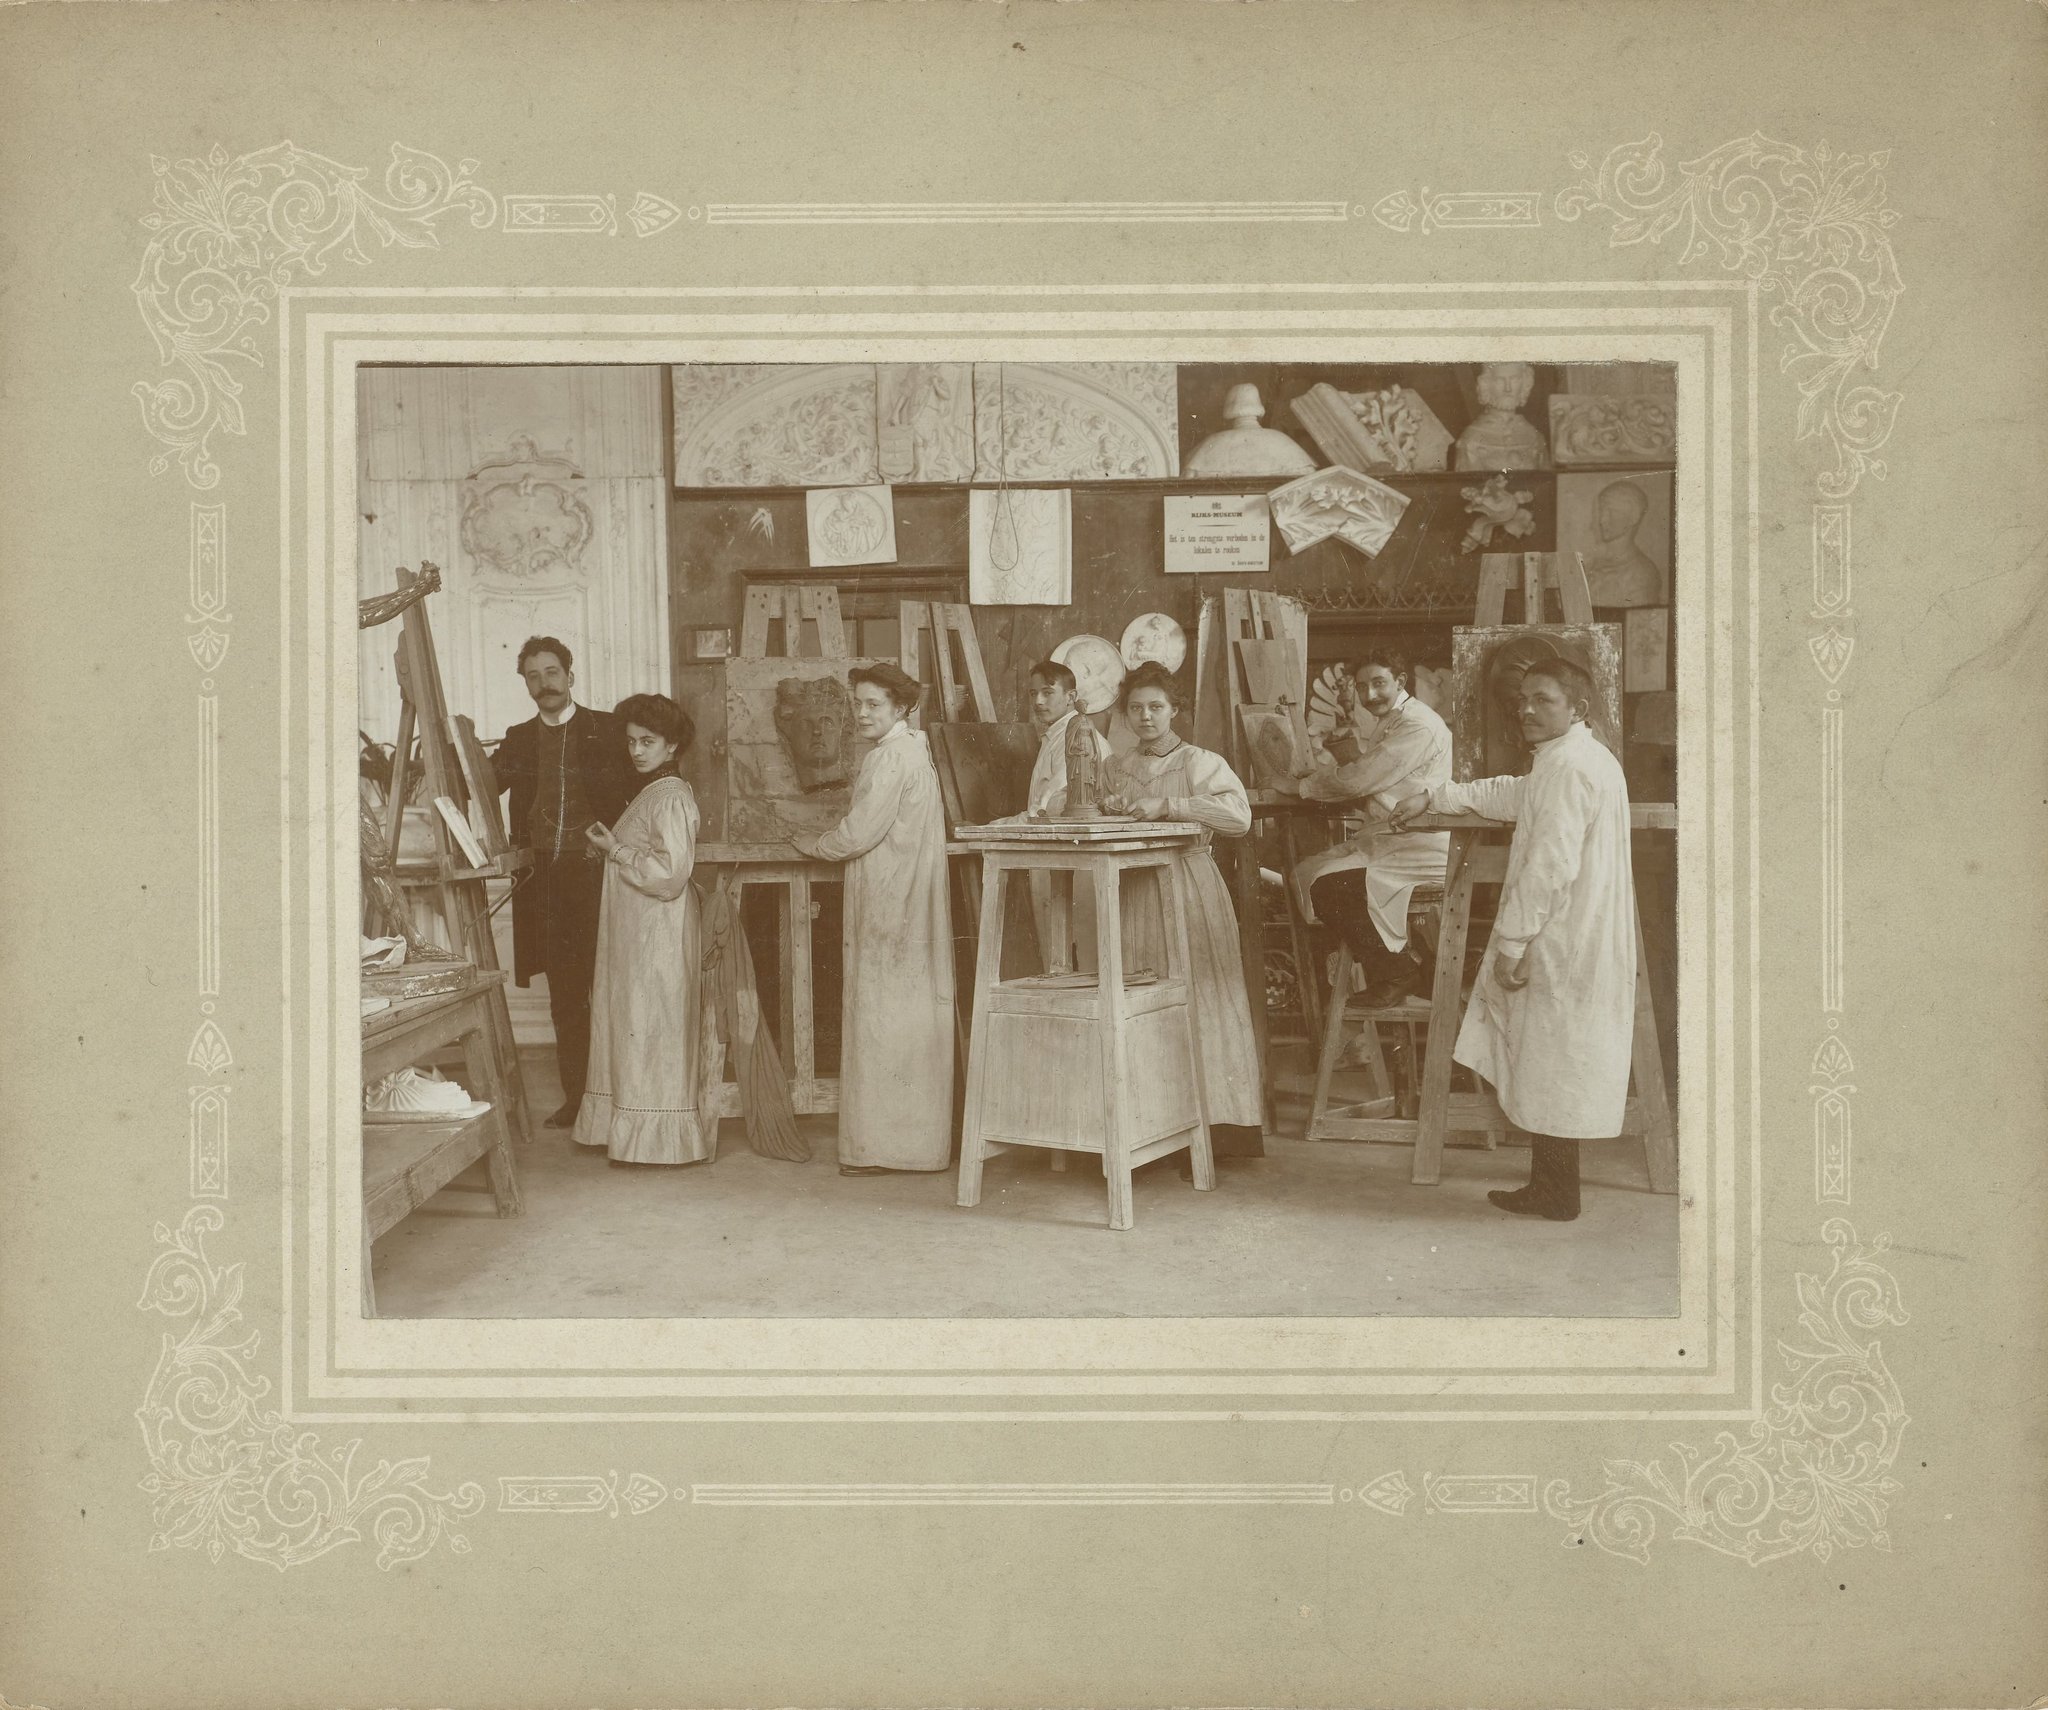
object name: photograph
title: Werkplaats Rijksmuseum, vermoedelijk opleidingsplaats voor leerlingen kunst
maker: Anonymous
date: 1900-1920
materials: cardboard, photographic support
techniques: albumen print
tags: workshop